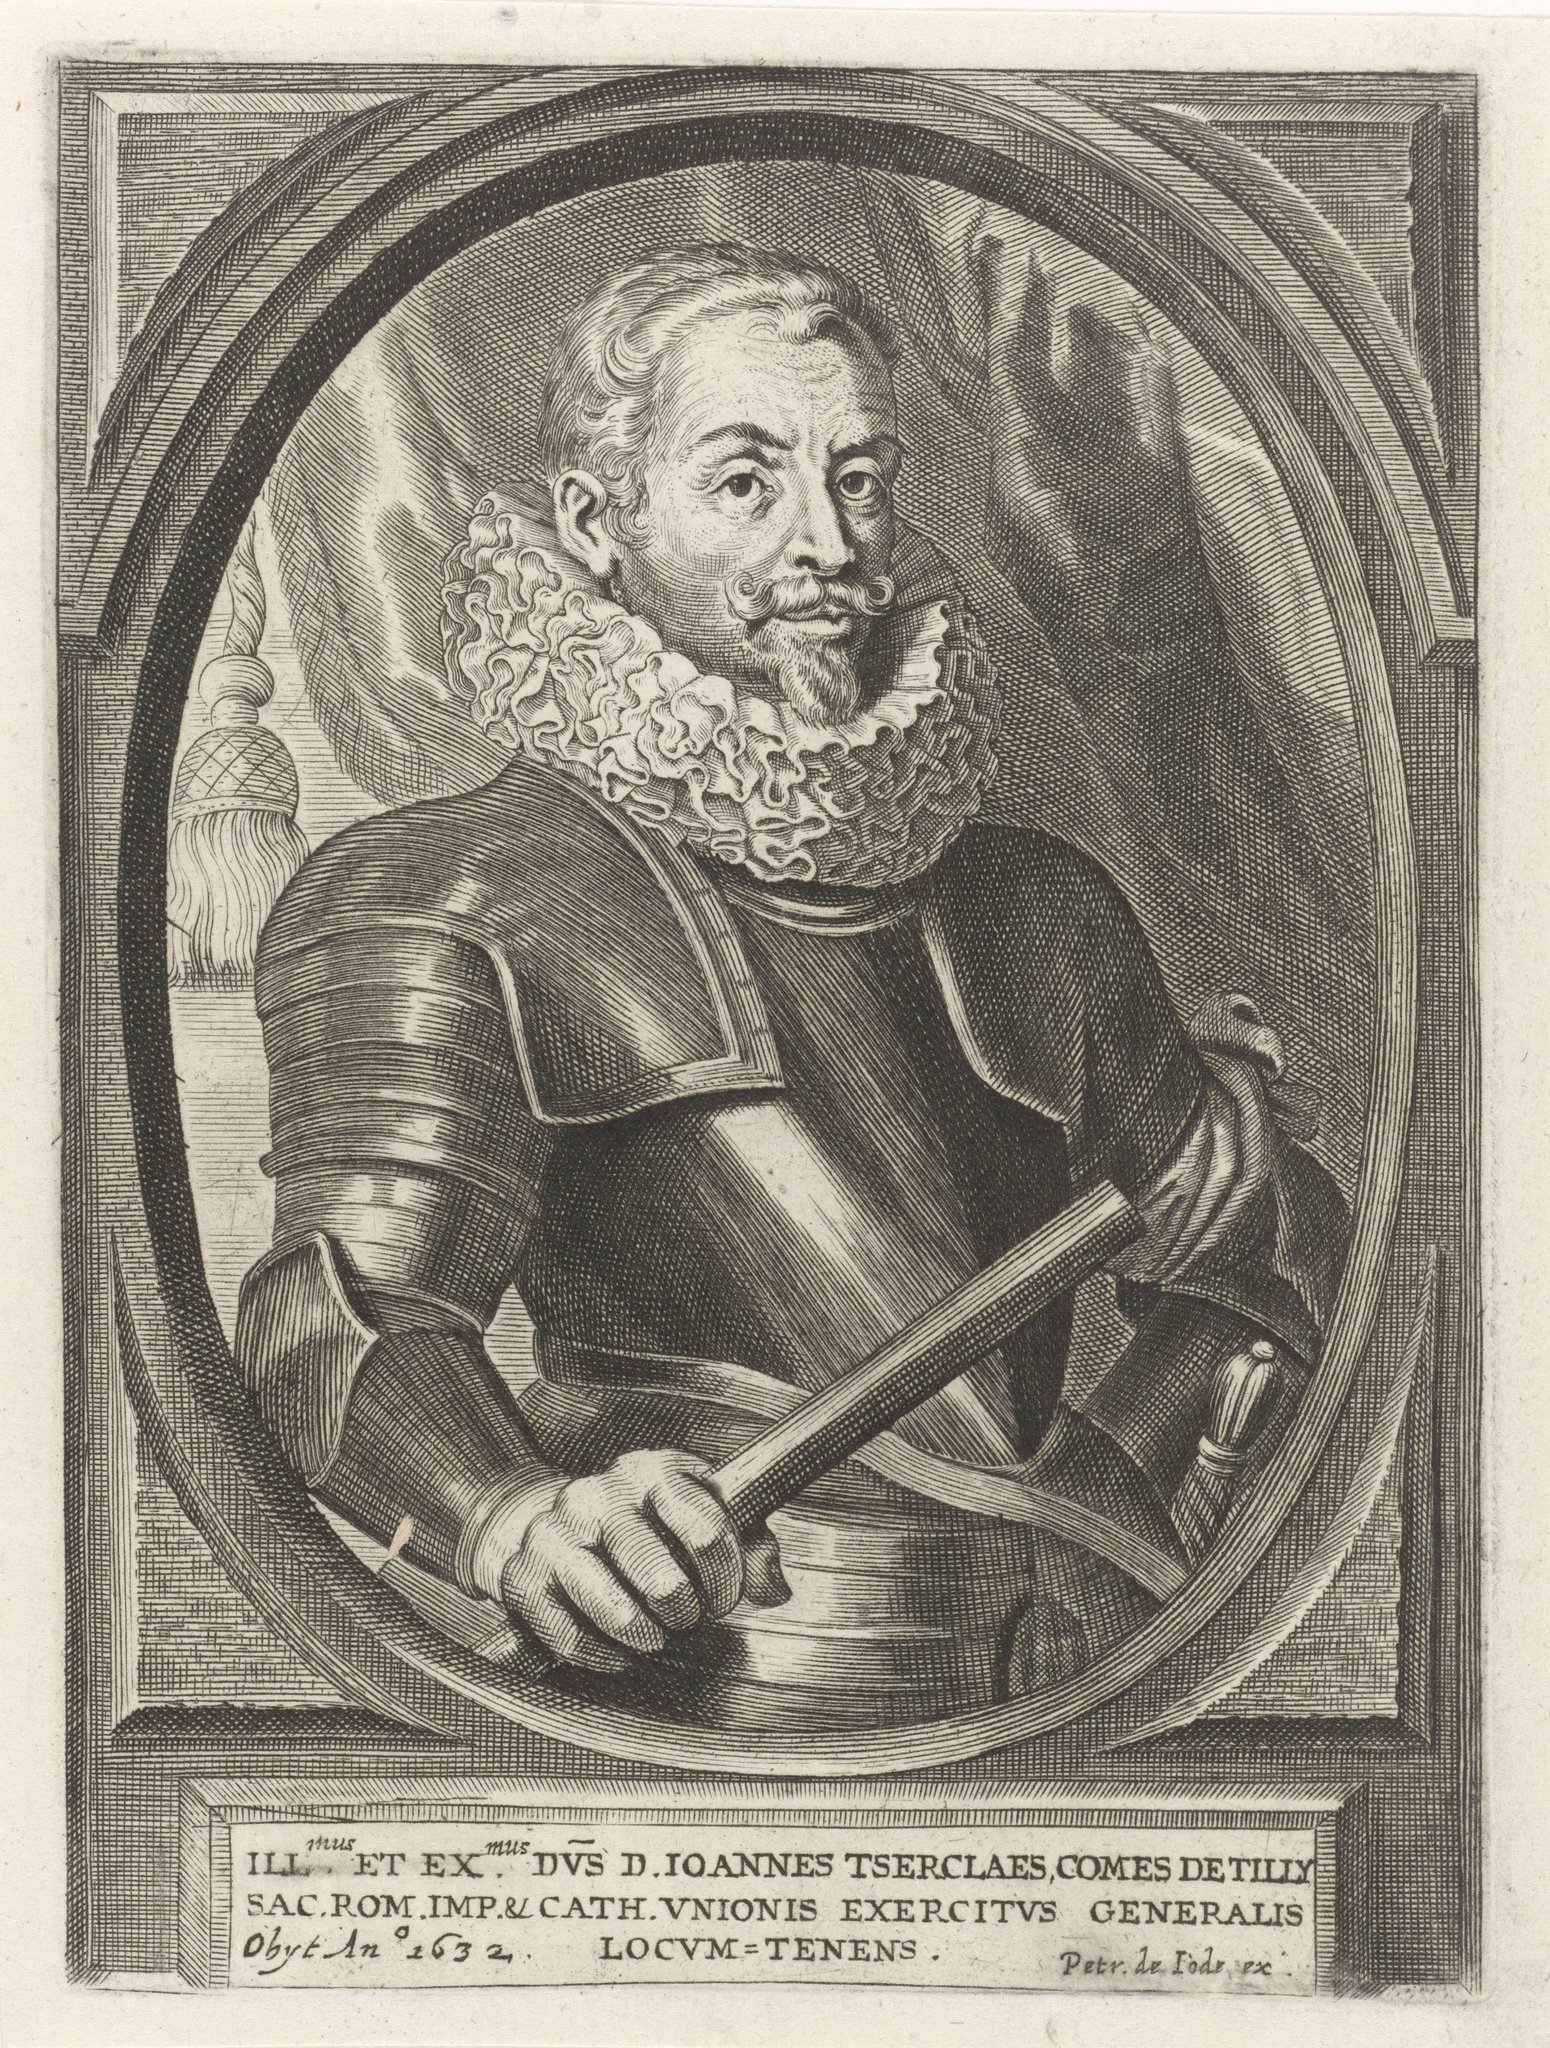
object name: print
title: Theater van bisschoppen, keizers, koningen, hertogen, prinsen, enz.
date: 1628-1670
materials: paper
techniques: engraving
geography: antwerp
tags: tilly, ingolstadt, huurling generaal, johan t' serclaes (graaf van tilly)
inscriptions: collector's mark: Lugt 2228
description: Portret van Johannes 't Serclaes, graaf van Tilly, ten halven lijve. In zijn rechterhand houdt hij een commandostaf. Het portret is gevat in een ovale omlijsting met vierkant randwerk. In de marge een drieregelig onderschrift in het Latijn.